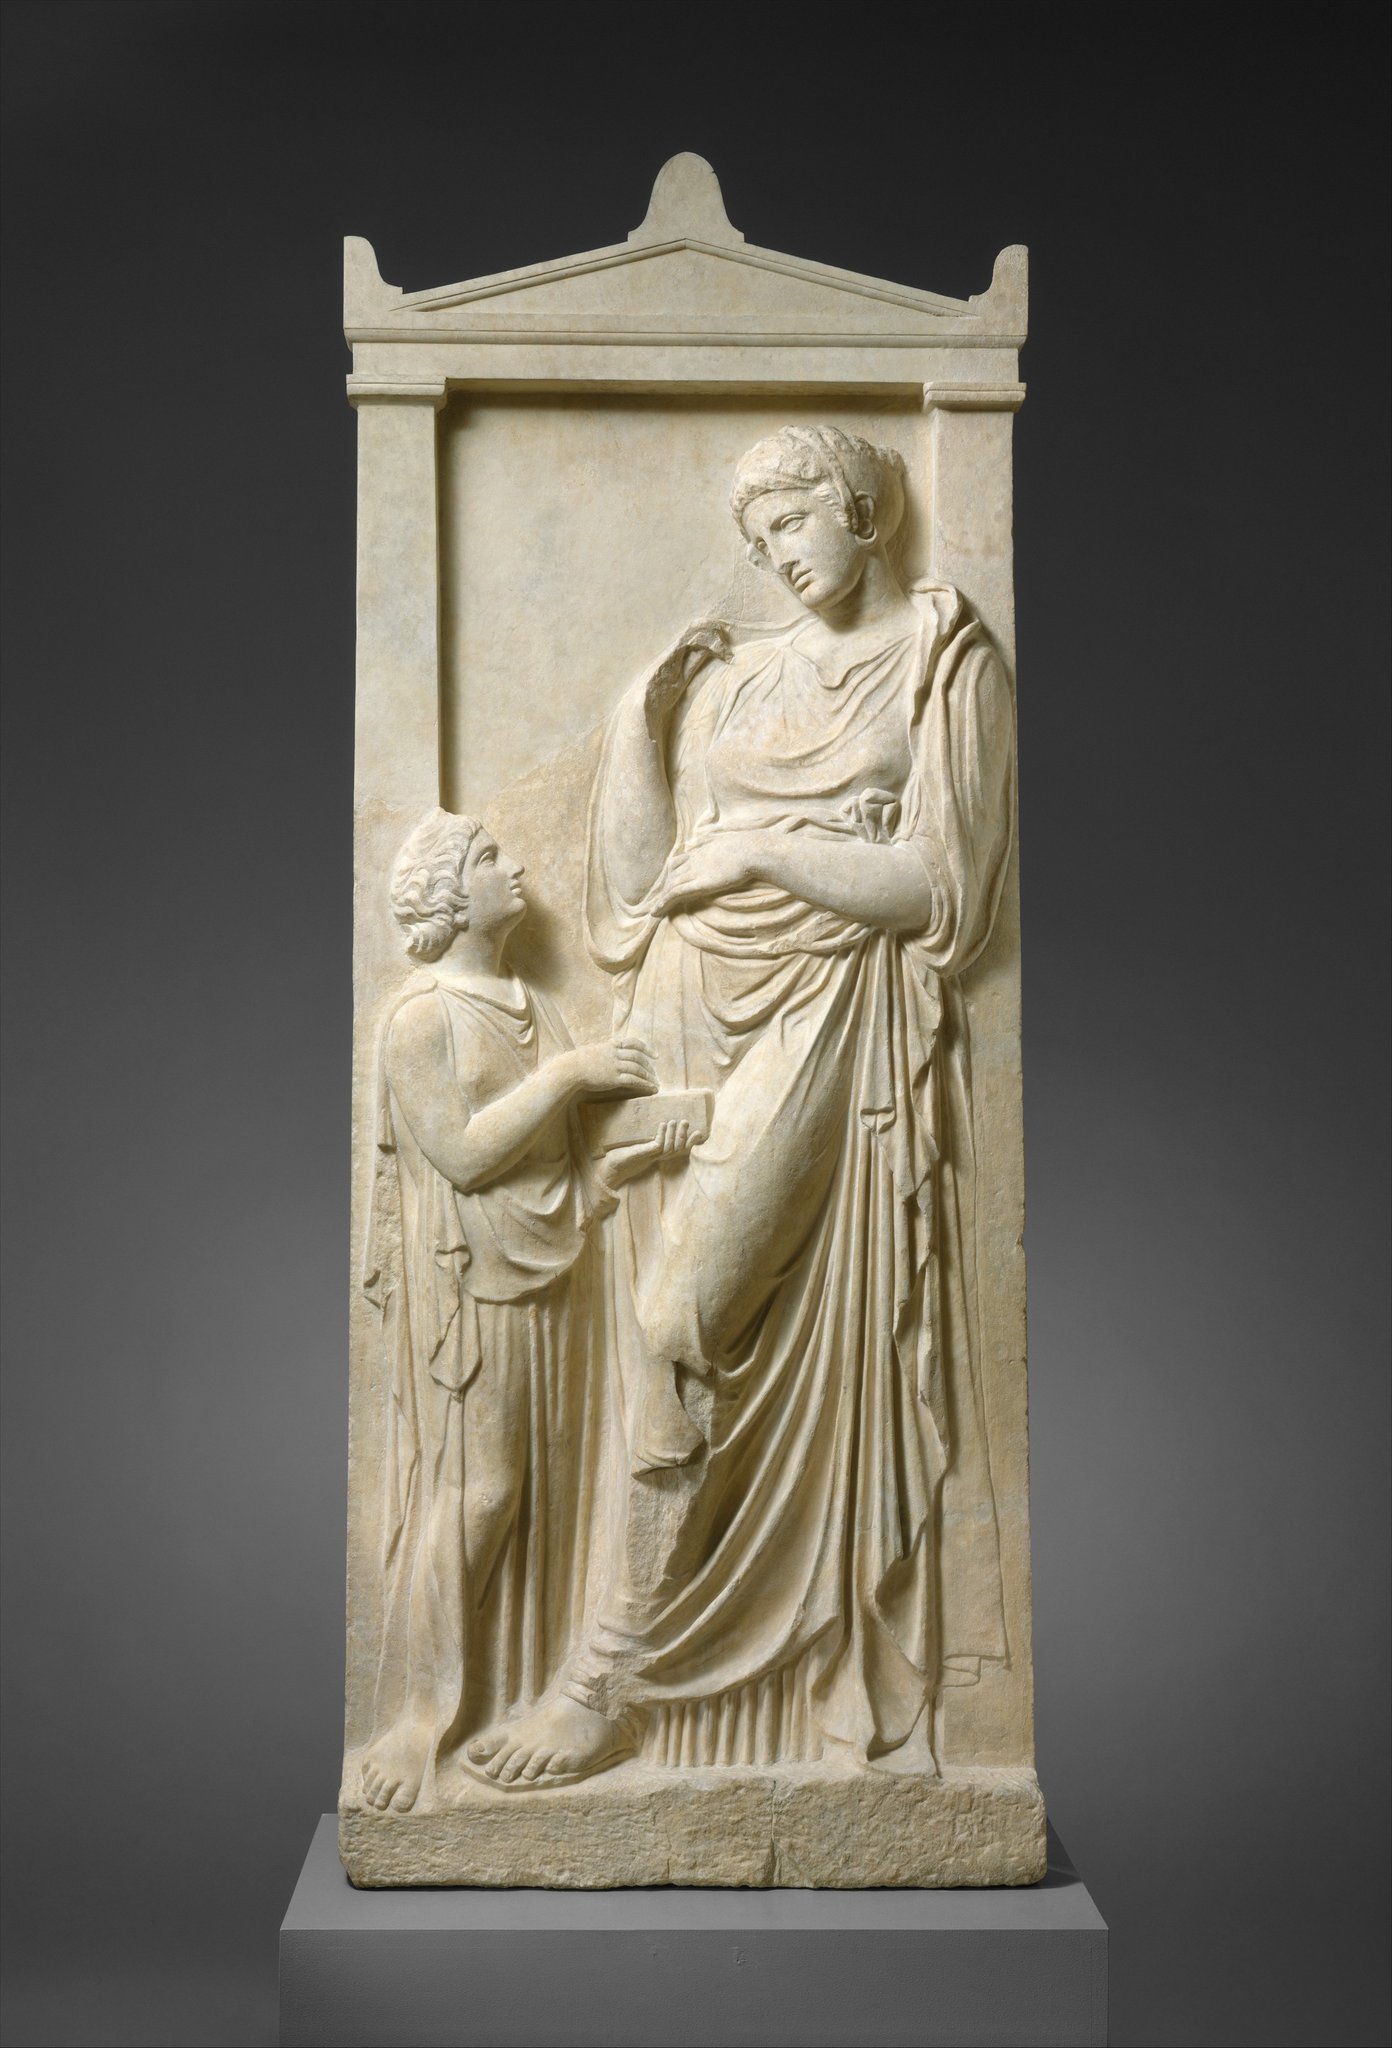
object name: grave stele of a woman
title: Marble grave stele of a young woman and servant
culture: greek, attic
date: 400-390 BCE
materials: marble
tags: men,women,servants